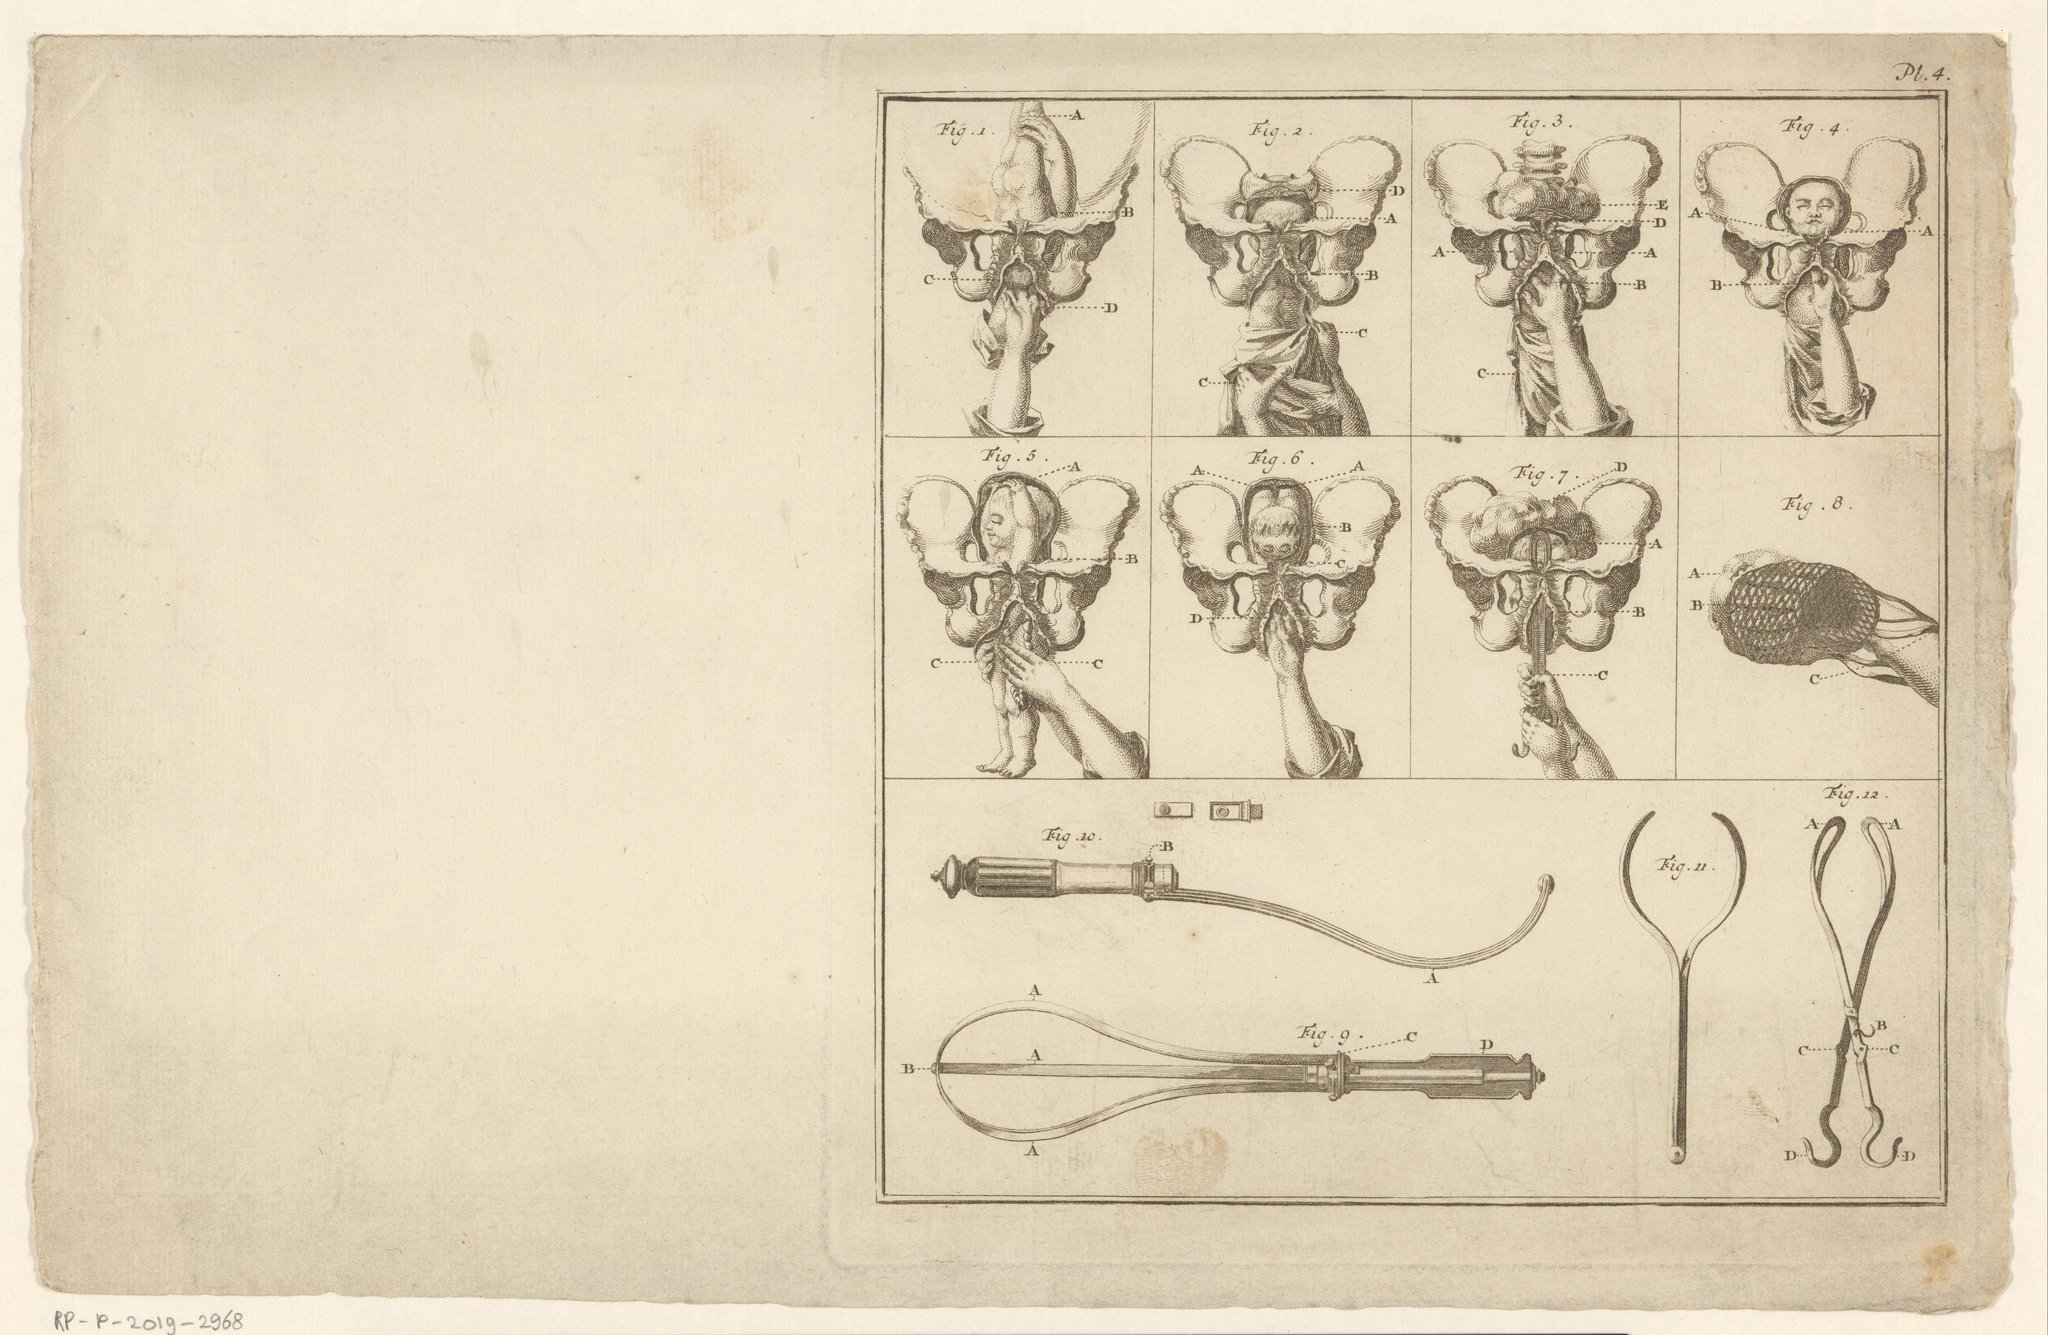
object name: print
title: Acht aanzichten van het verlossen van een baby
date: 1700-1799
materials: paper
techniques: etching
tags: gynaecology, obstetrics, woman giving birth (lying-in)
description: Acht verschillende aanzichten van de manier waarop baby's verlost kunnen worden. De aanzichten zijn voorzien van letters. Onderaan nog een negende aanzicht met medische instrumenten bestemd voor een verlossing. Genummerd rechtsboven: Pl. 4.